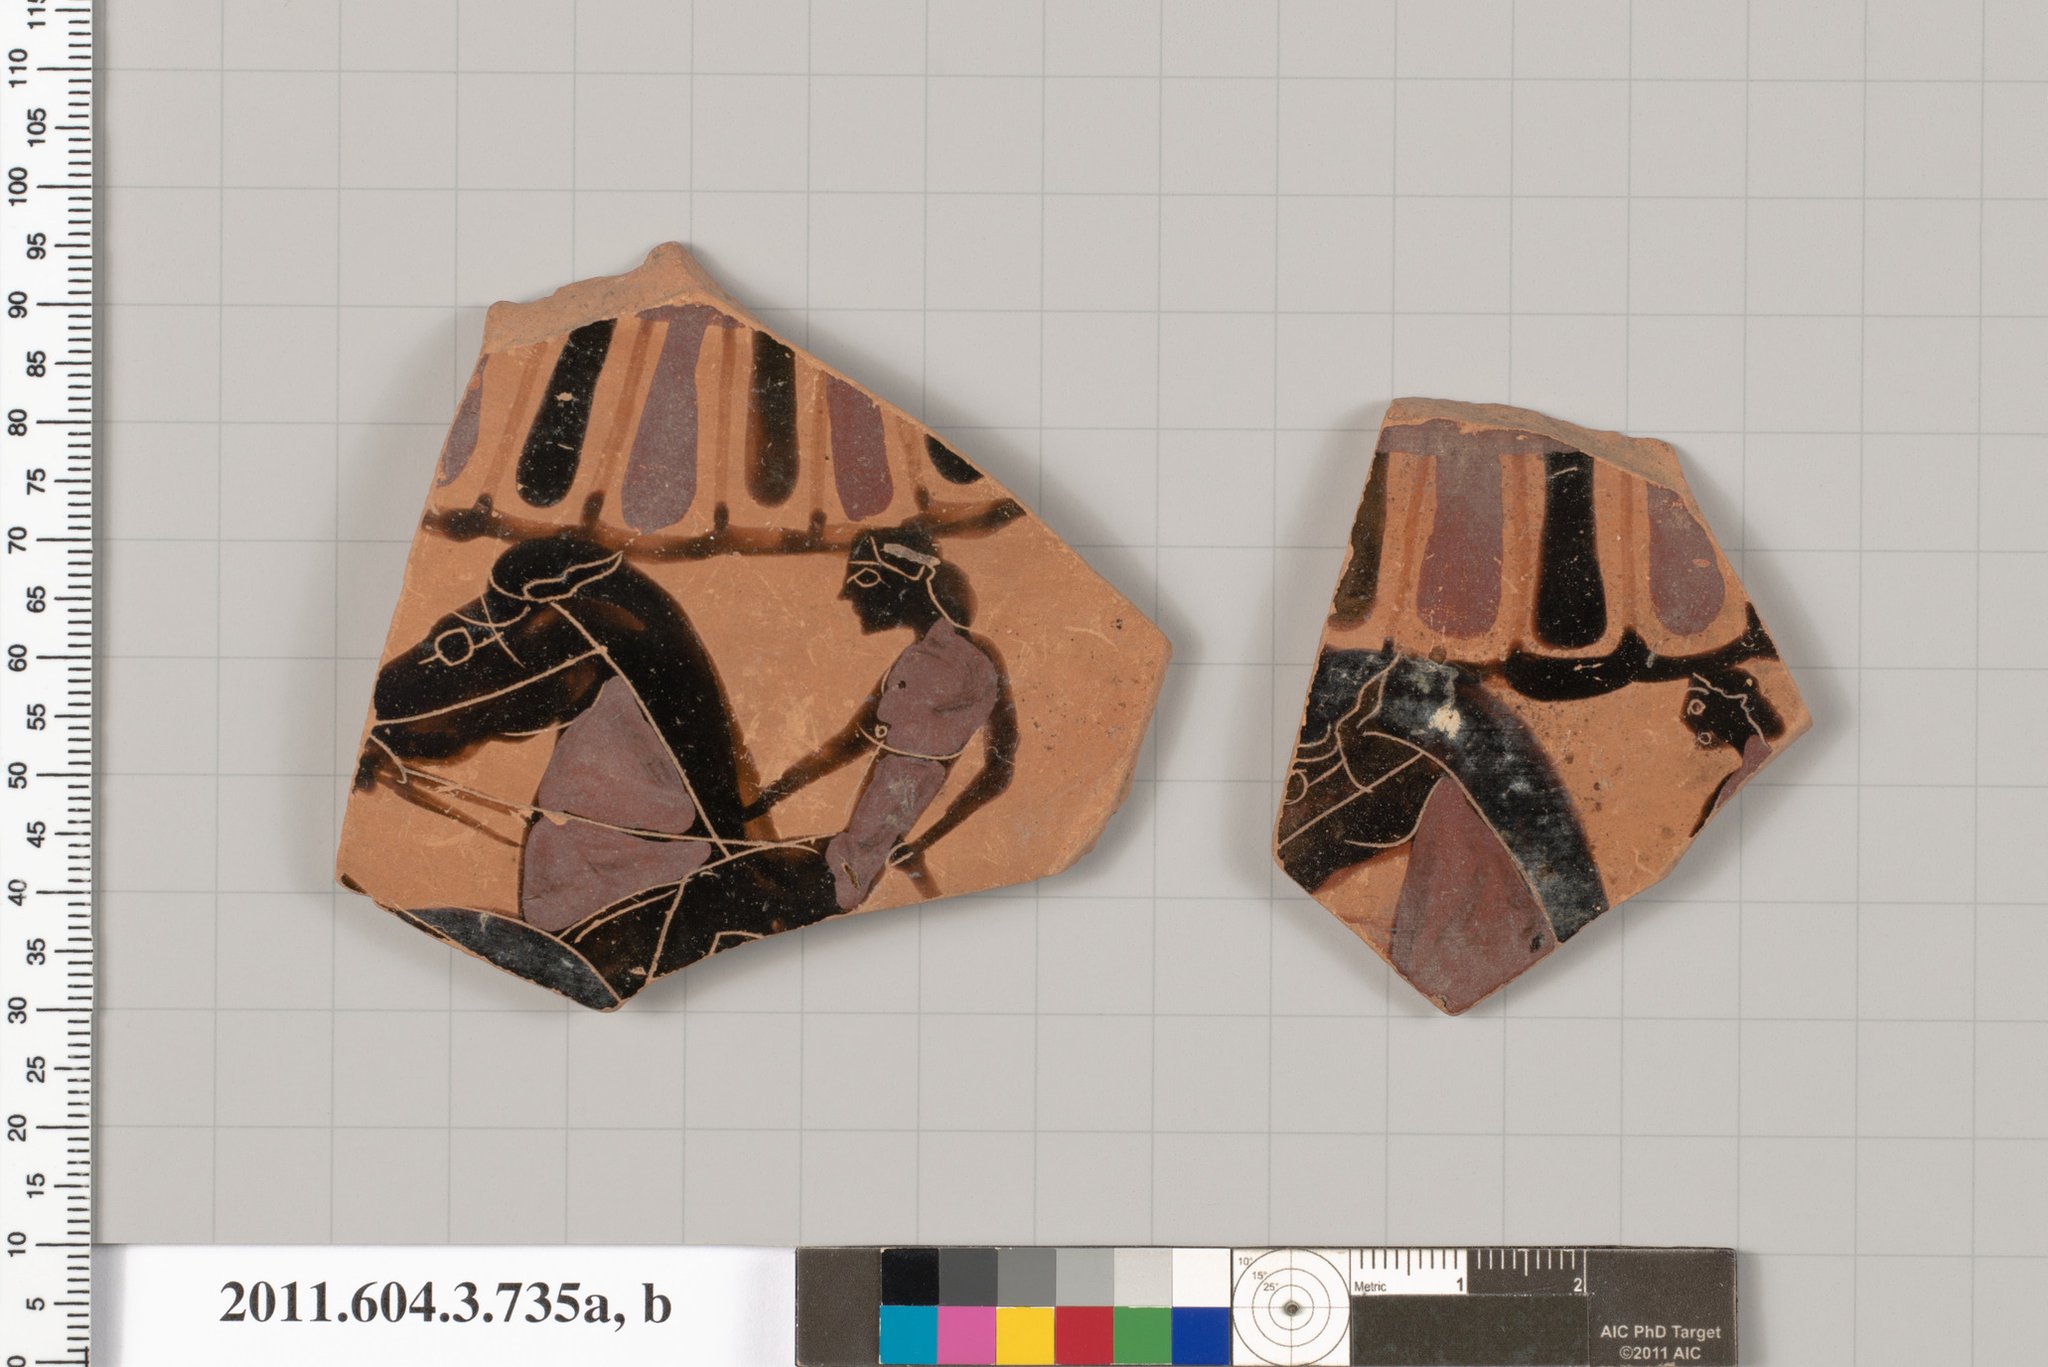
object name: neck amphora, tyrrhenian fragment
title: Terracotta fragments of a neck-amphora (jar)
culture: greek, attic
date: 575-551 BCE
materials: terracotta